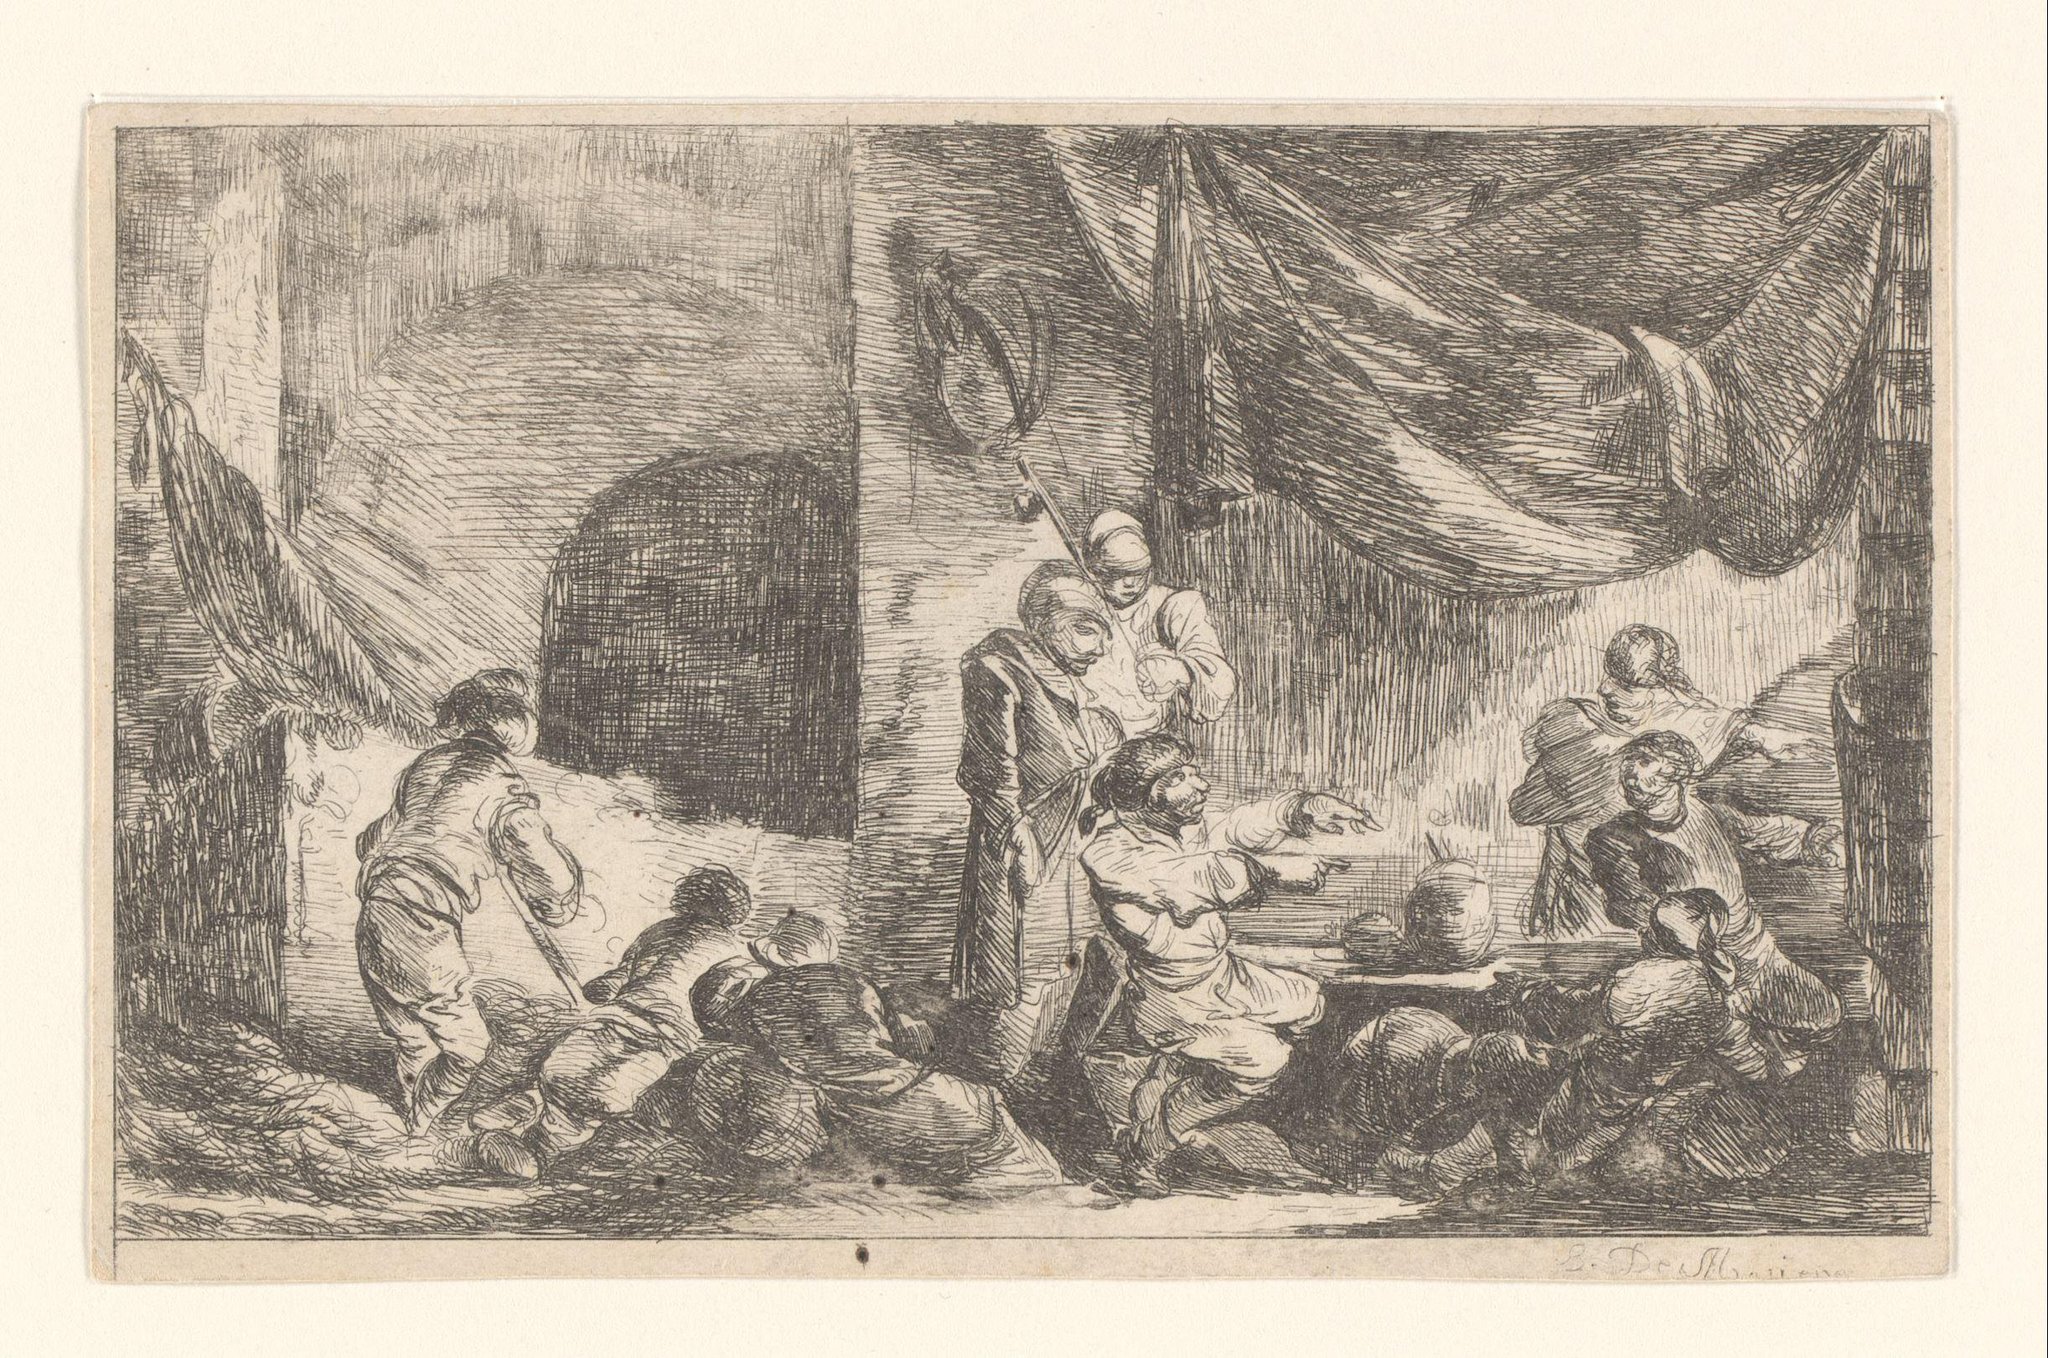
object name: print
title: Soldaten bij een stal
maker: Anonymous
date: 1650-1750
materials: paper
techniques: etching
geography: france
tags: the soldier off duty, stall, stable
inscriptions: signature: ‘B. de [Mariene?]’, collector's mark: Lugt 2228